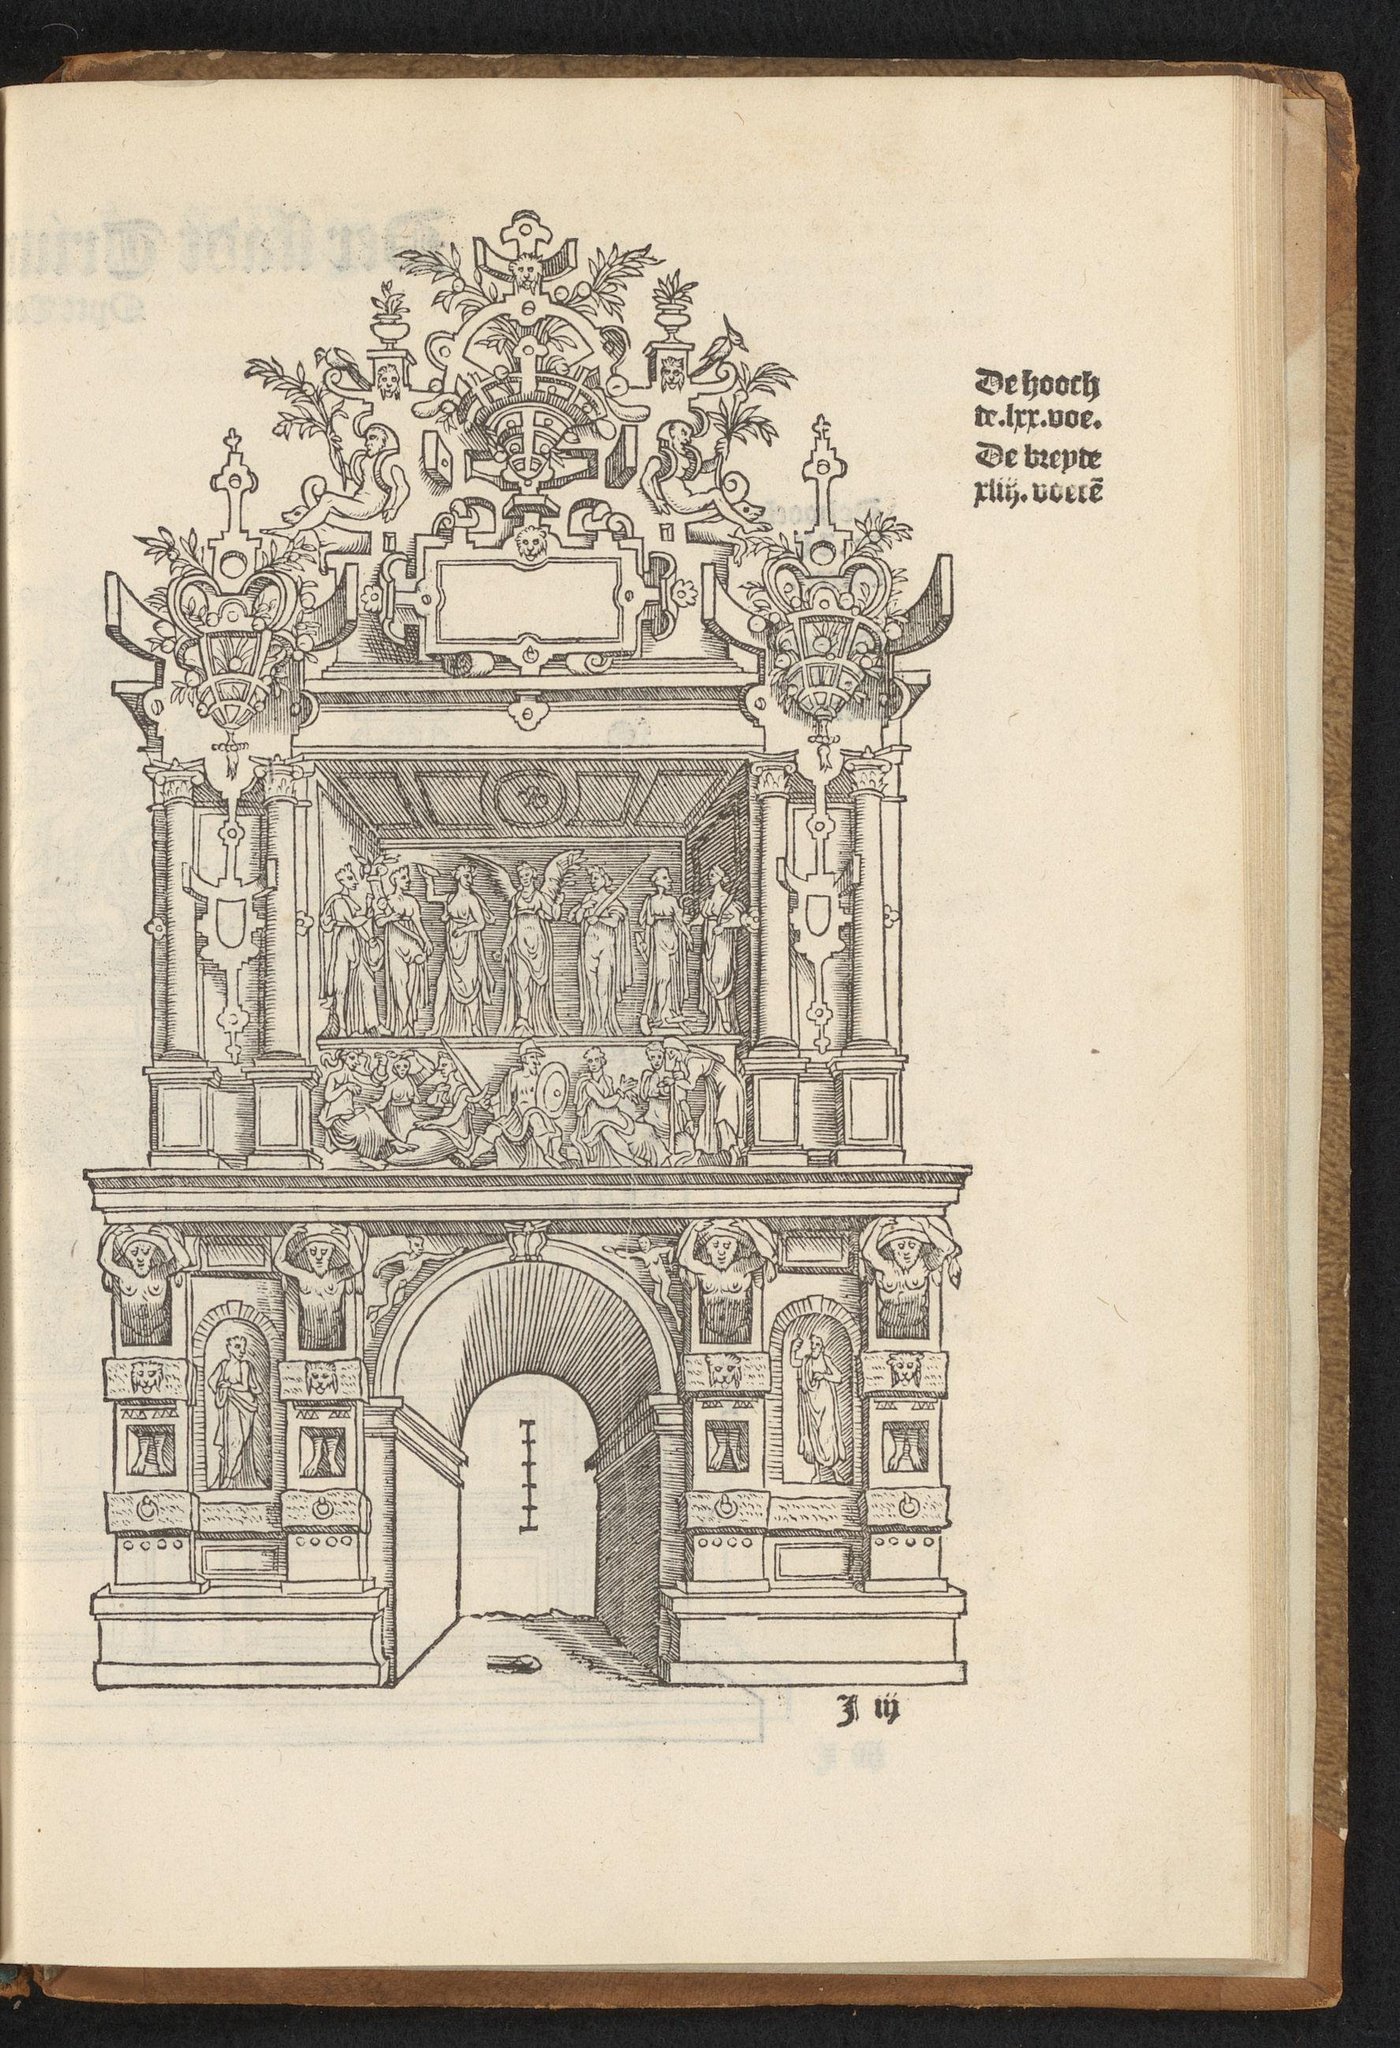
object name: print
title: De triomfboog van de stad aan de Minderbroedersbrug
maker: pieter coecke van aelst (i)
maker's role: draughtsman, print maker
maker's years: 1502-1550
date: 1549-1550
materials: paper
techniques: woodcut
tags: philip ii of spain, 'tableau vivant', triumphal arch, antwerp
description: Illustratie in de Nederlandse vertaling van de beschrijving van de intocht van Filips II in Antwerpen in 1549: De seer wonderlijcke schoone triumphelijcke incompst, van den hooghmogenden Prince Philips, Prince van Spaignen, Caroli des vijfden, Keysers sone : inde stadt van Antwerpen, Anno 1549. Tekst van Cornelius Grapheus, waarschijnlijk vertaald uit het Latijn door Gillis van Diest, opgedragen aan Filips II, uitgegeven met keizerlijke privilege door Pieter Coecke van Aelst, gedrukt door Gillis van Diest. Boek in de bibliotheek met signatuur: 325 B 12.